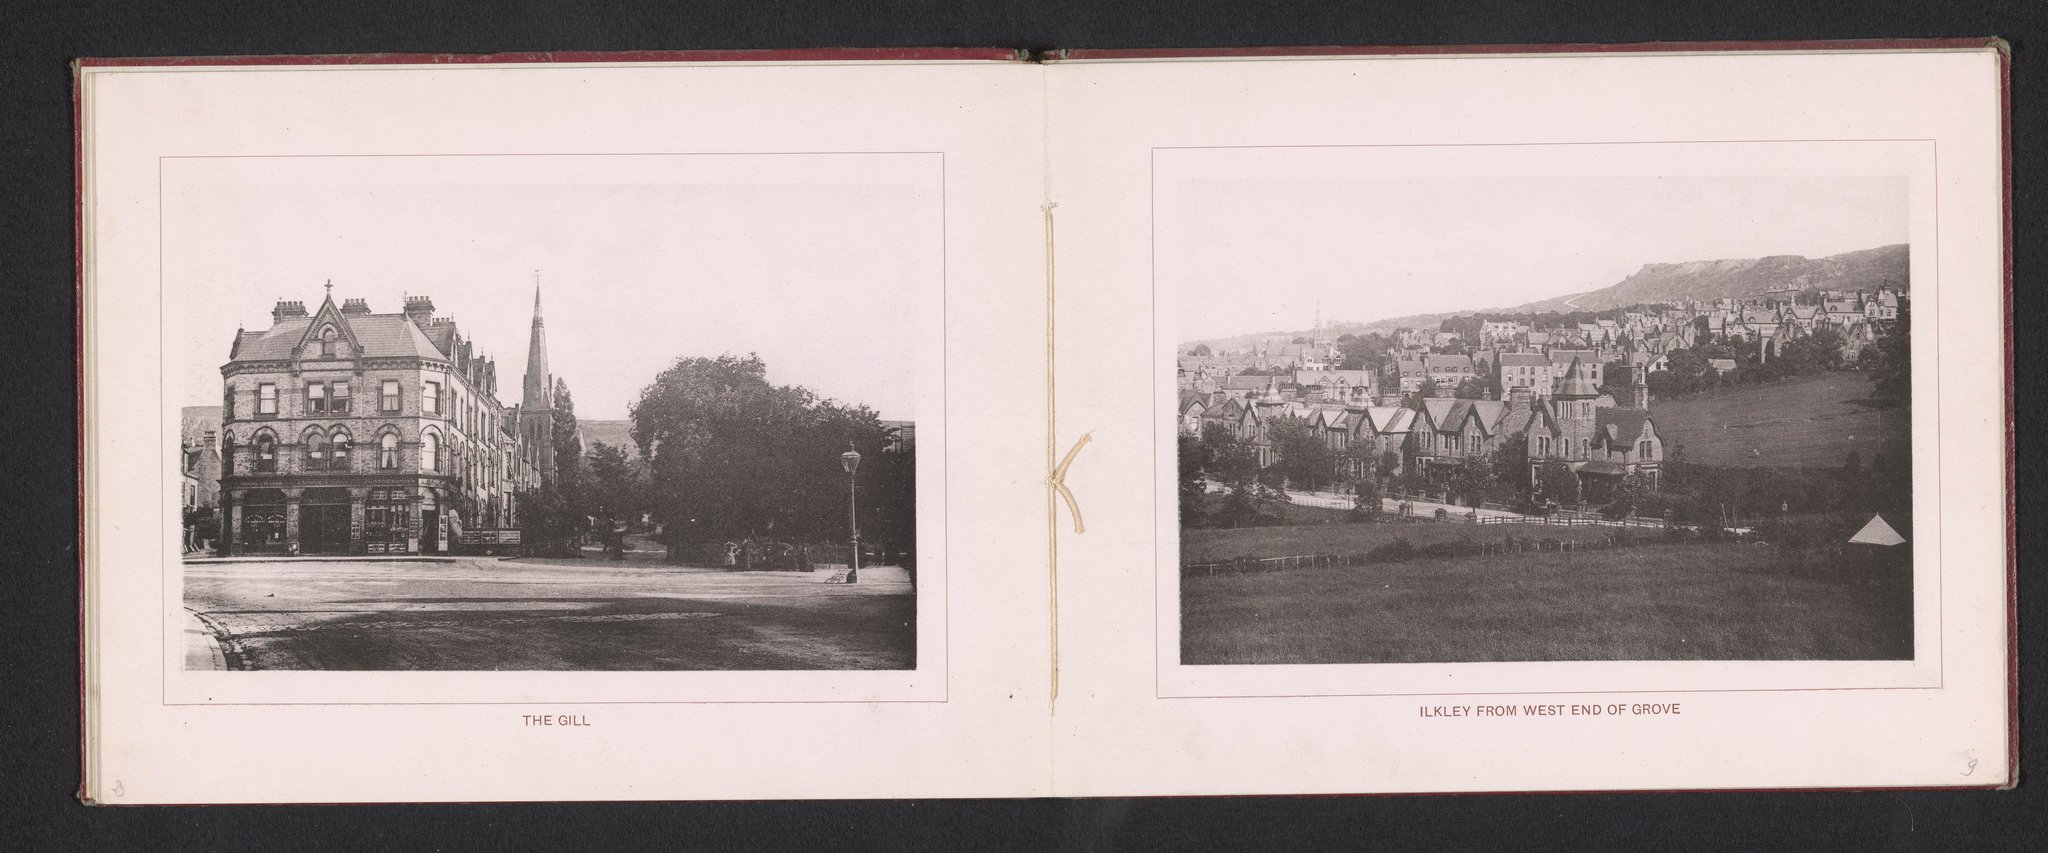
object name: photomechanical print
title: The gill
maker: Anonymous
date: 1890-1900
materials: paper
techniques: photograph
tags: square, place, circus, etc., façade (of house or building)